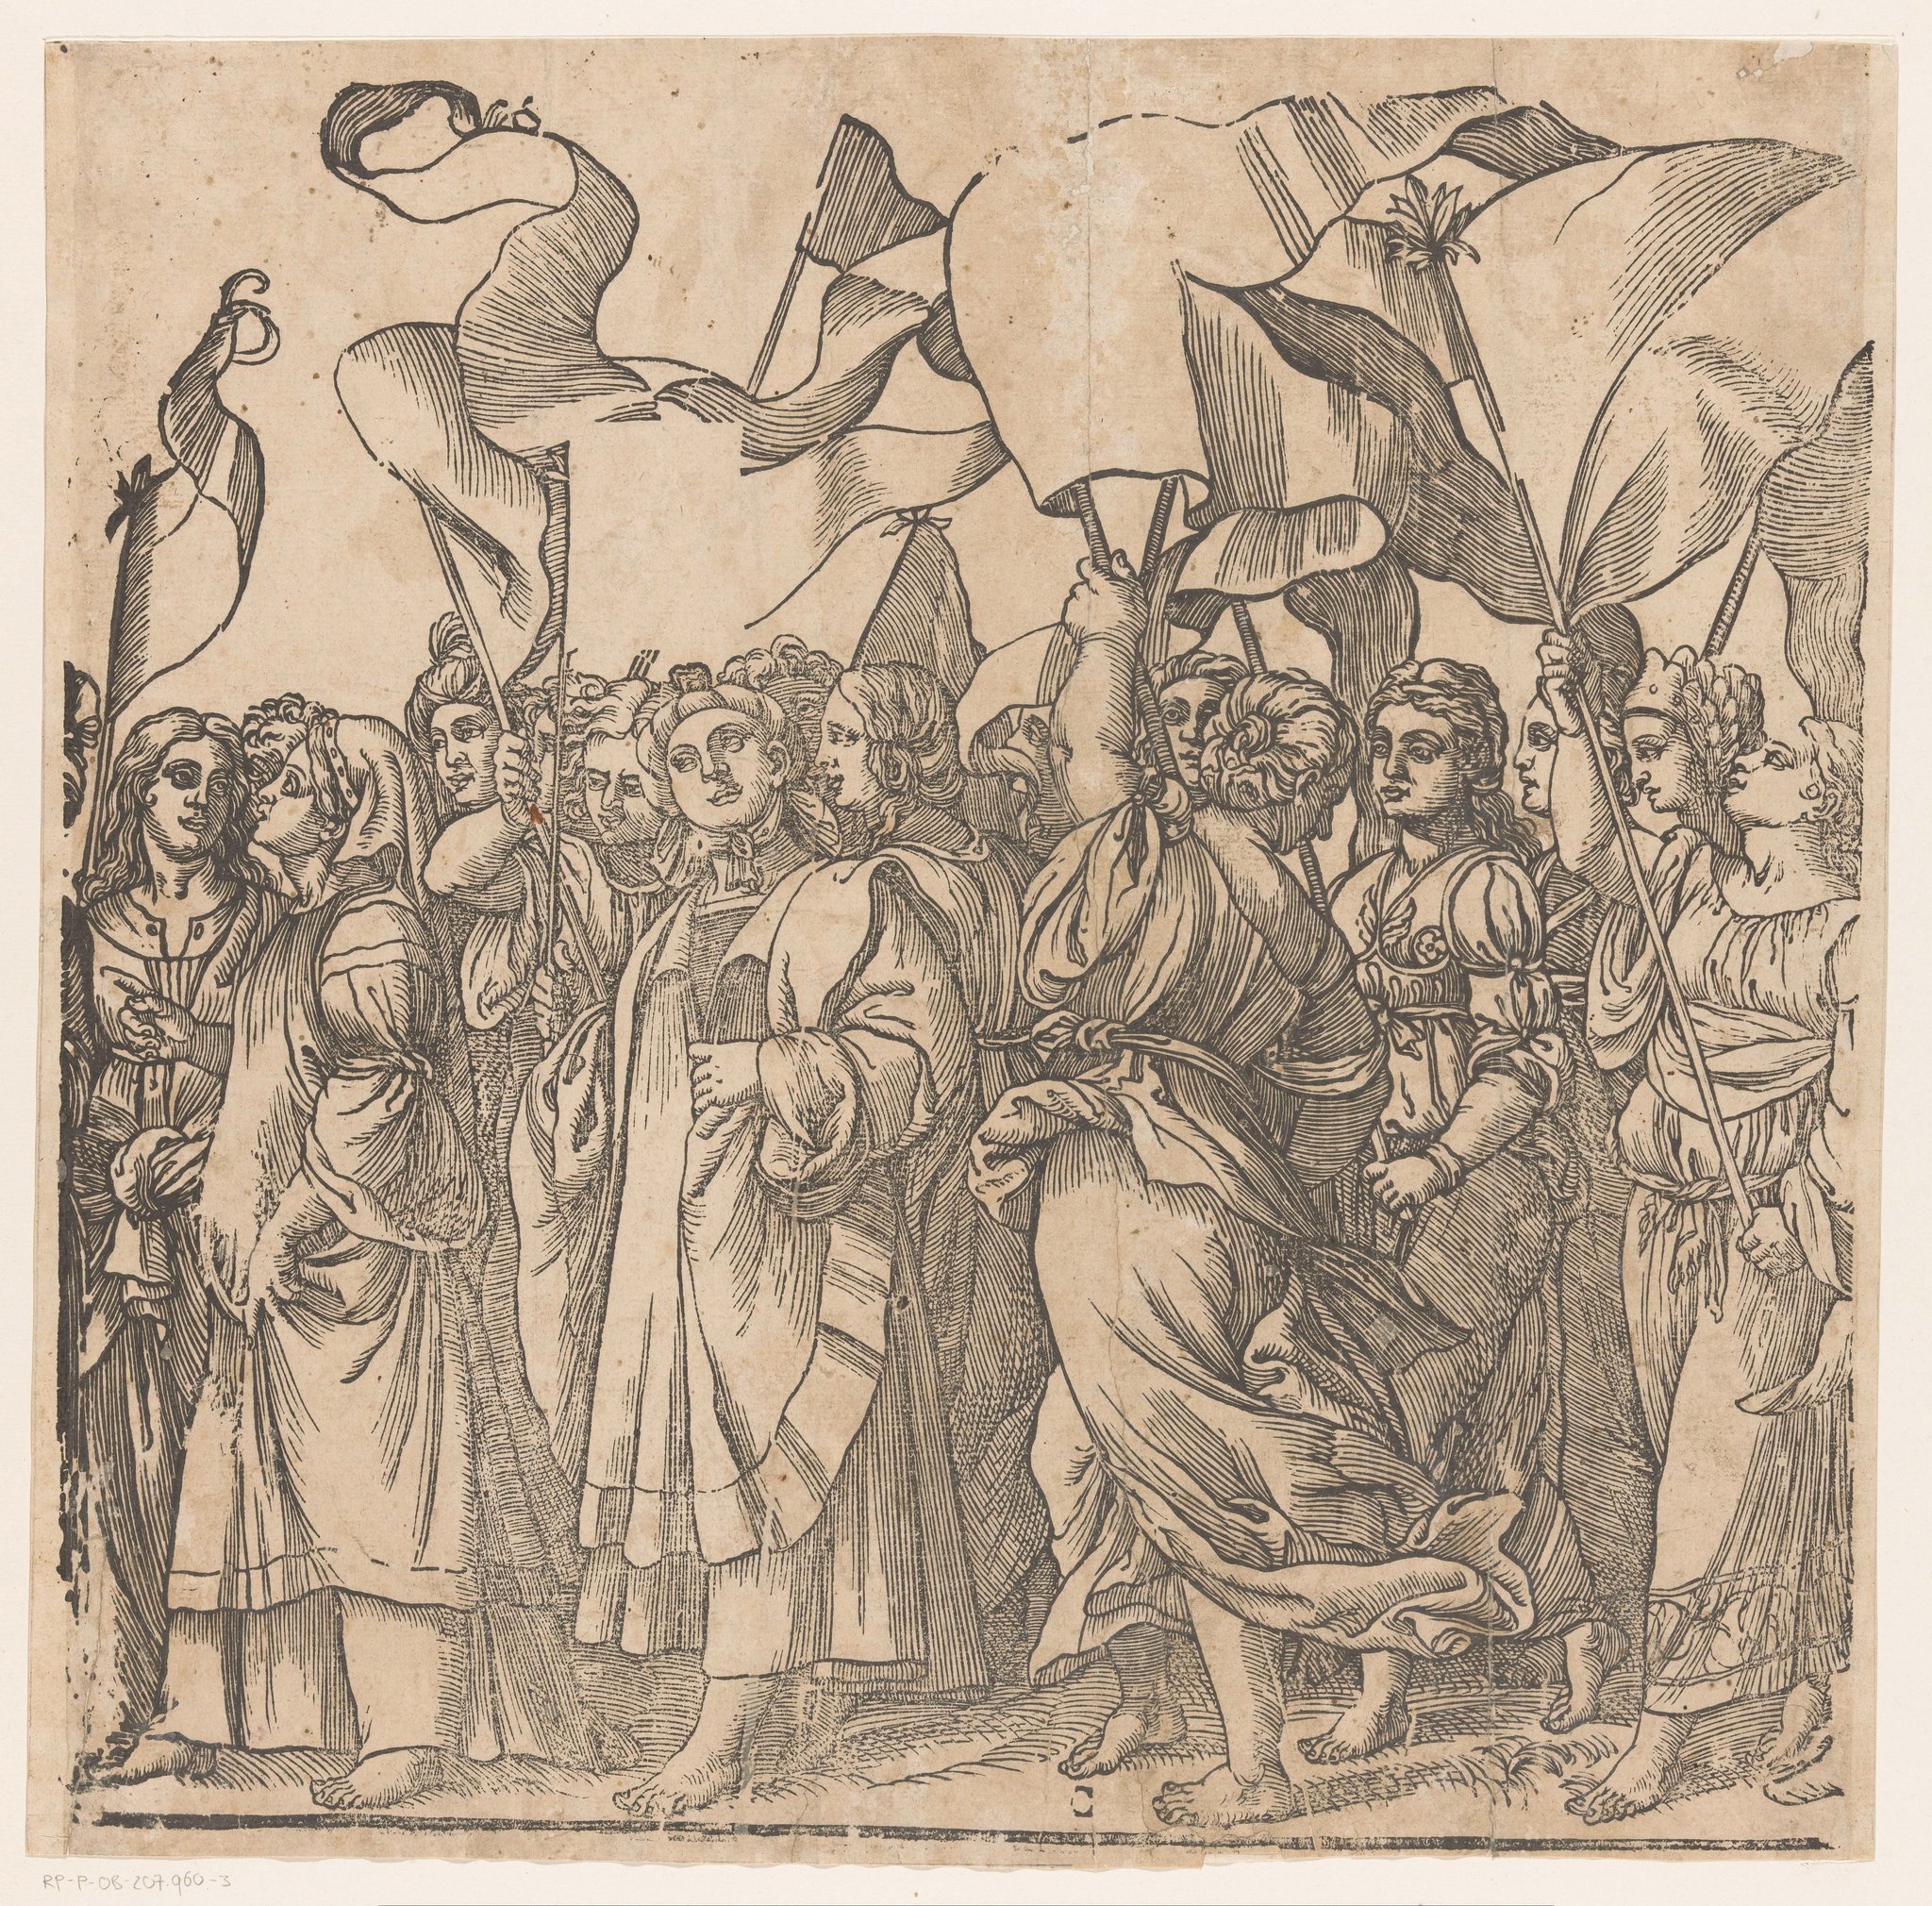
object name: print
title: Triomf van Christus (derde deel)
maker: andrea andreani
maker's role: print maker, printer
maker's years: 1558-1629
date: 1568-1629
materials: paper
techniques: woodcut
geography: italy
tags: sibyls, banner, standard (as symbol of the state, etc.)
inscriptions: collector's mark: Lugt 2228, collector's mark: Lugt 240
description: Deze prent maakt onderdeel uit van een fries bestaande uit acht houtsneden die samen de Triomf van Christus vormen, gemerkt met letters A-H.